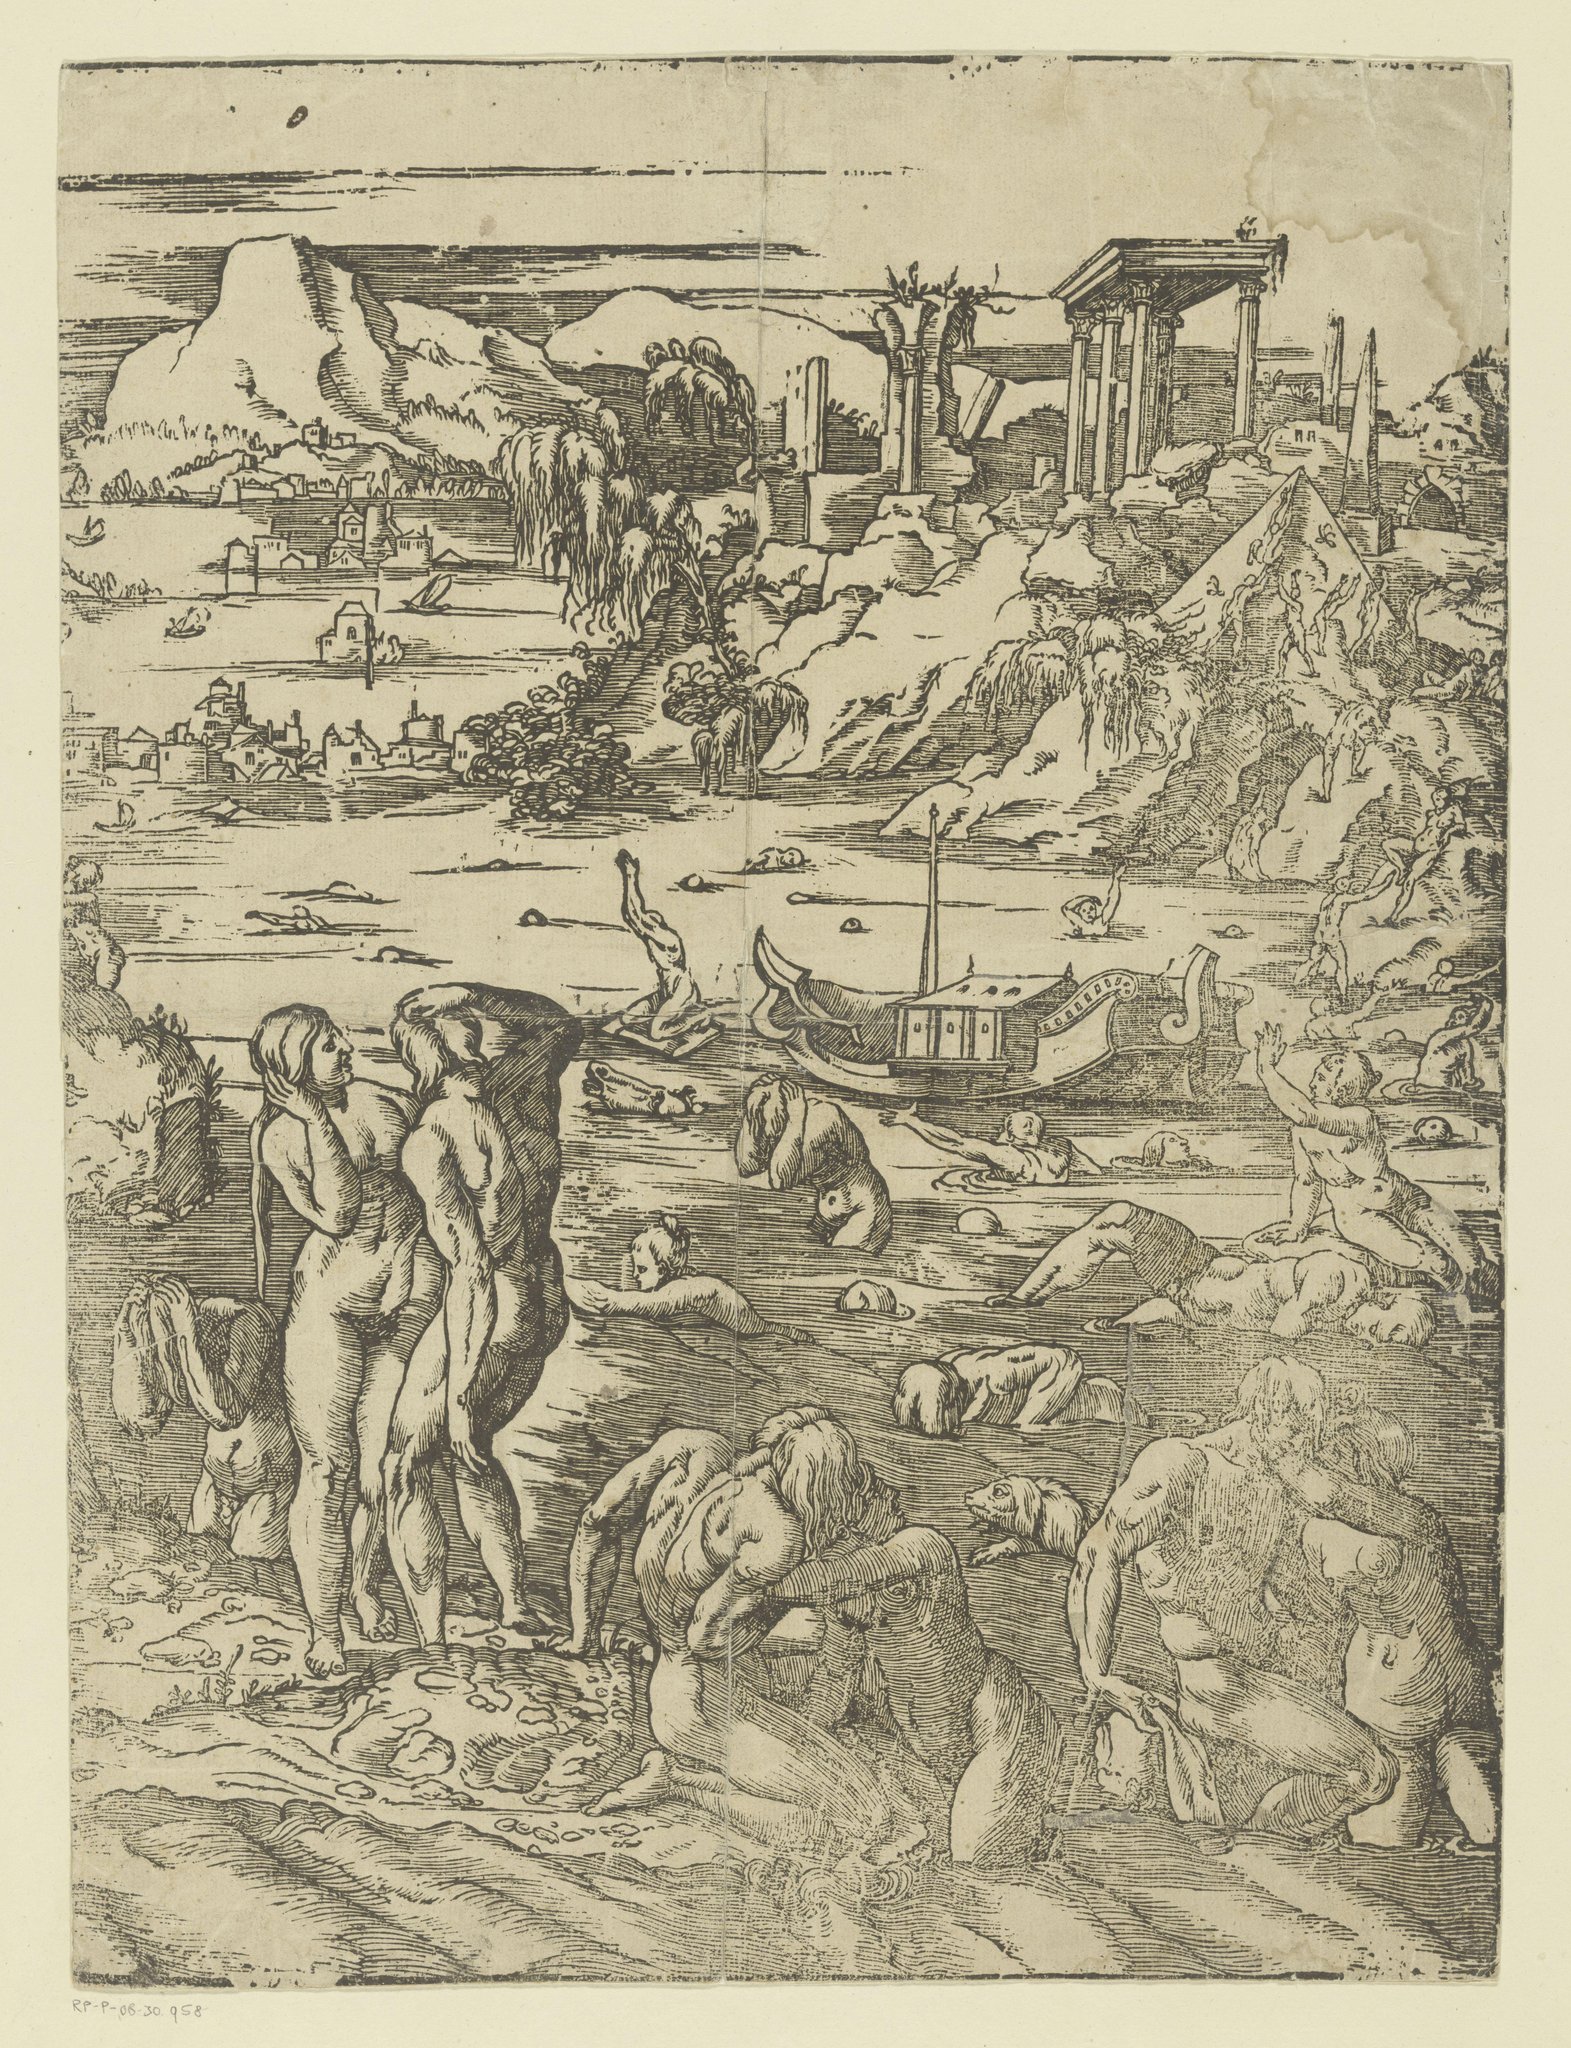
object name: print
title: Zondvloed (rechterhelft)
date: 1568-1629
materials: paper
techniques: woodcut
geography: venice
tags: the ark is floating on the waters, while life on earth is destroyed ~ story of noah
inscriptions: collector's mark: Lugt 240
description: Mannen en vrouwen proberen zichzelf en anderen in veiligheid te brengen tijdens de Zondvloed. Rechts een tempel en op het water de ark van Noach.